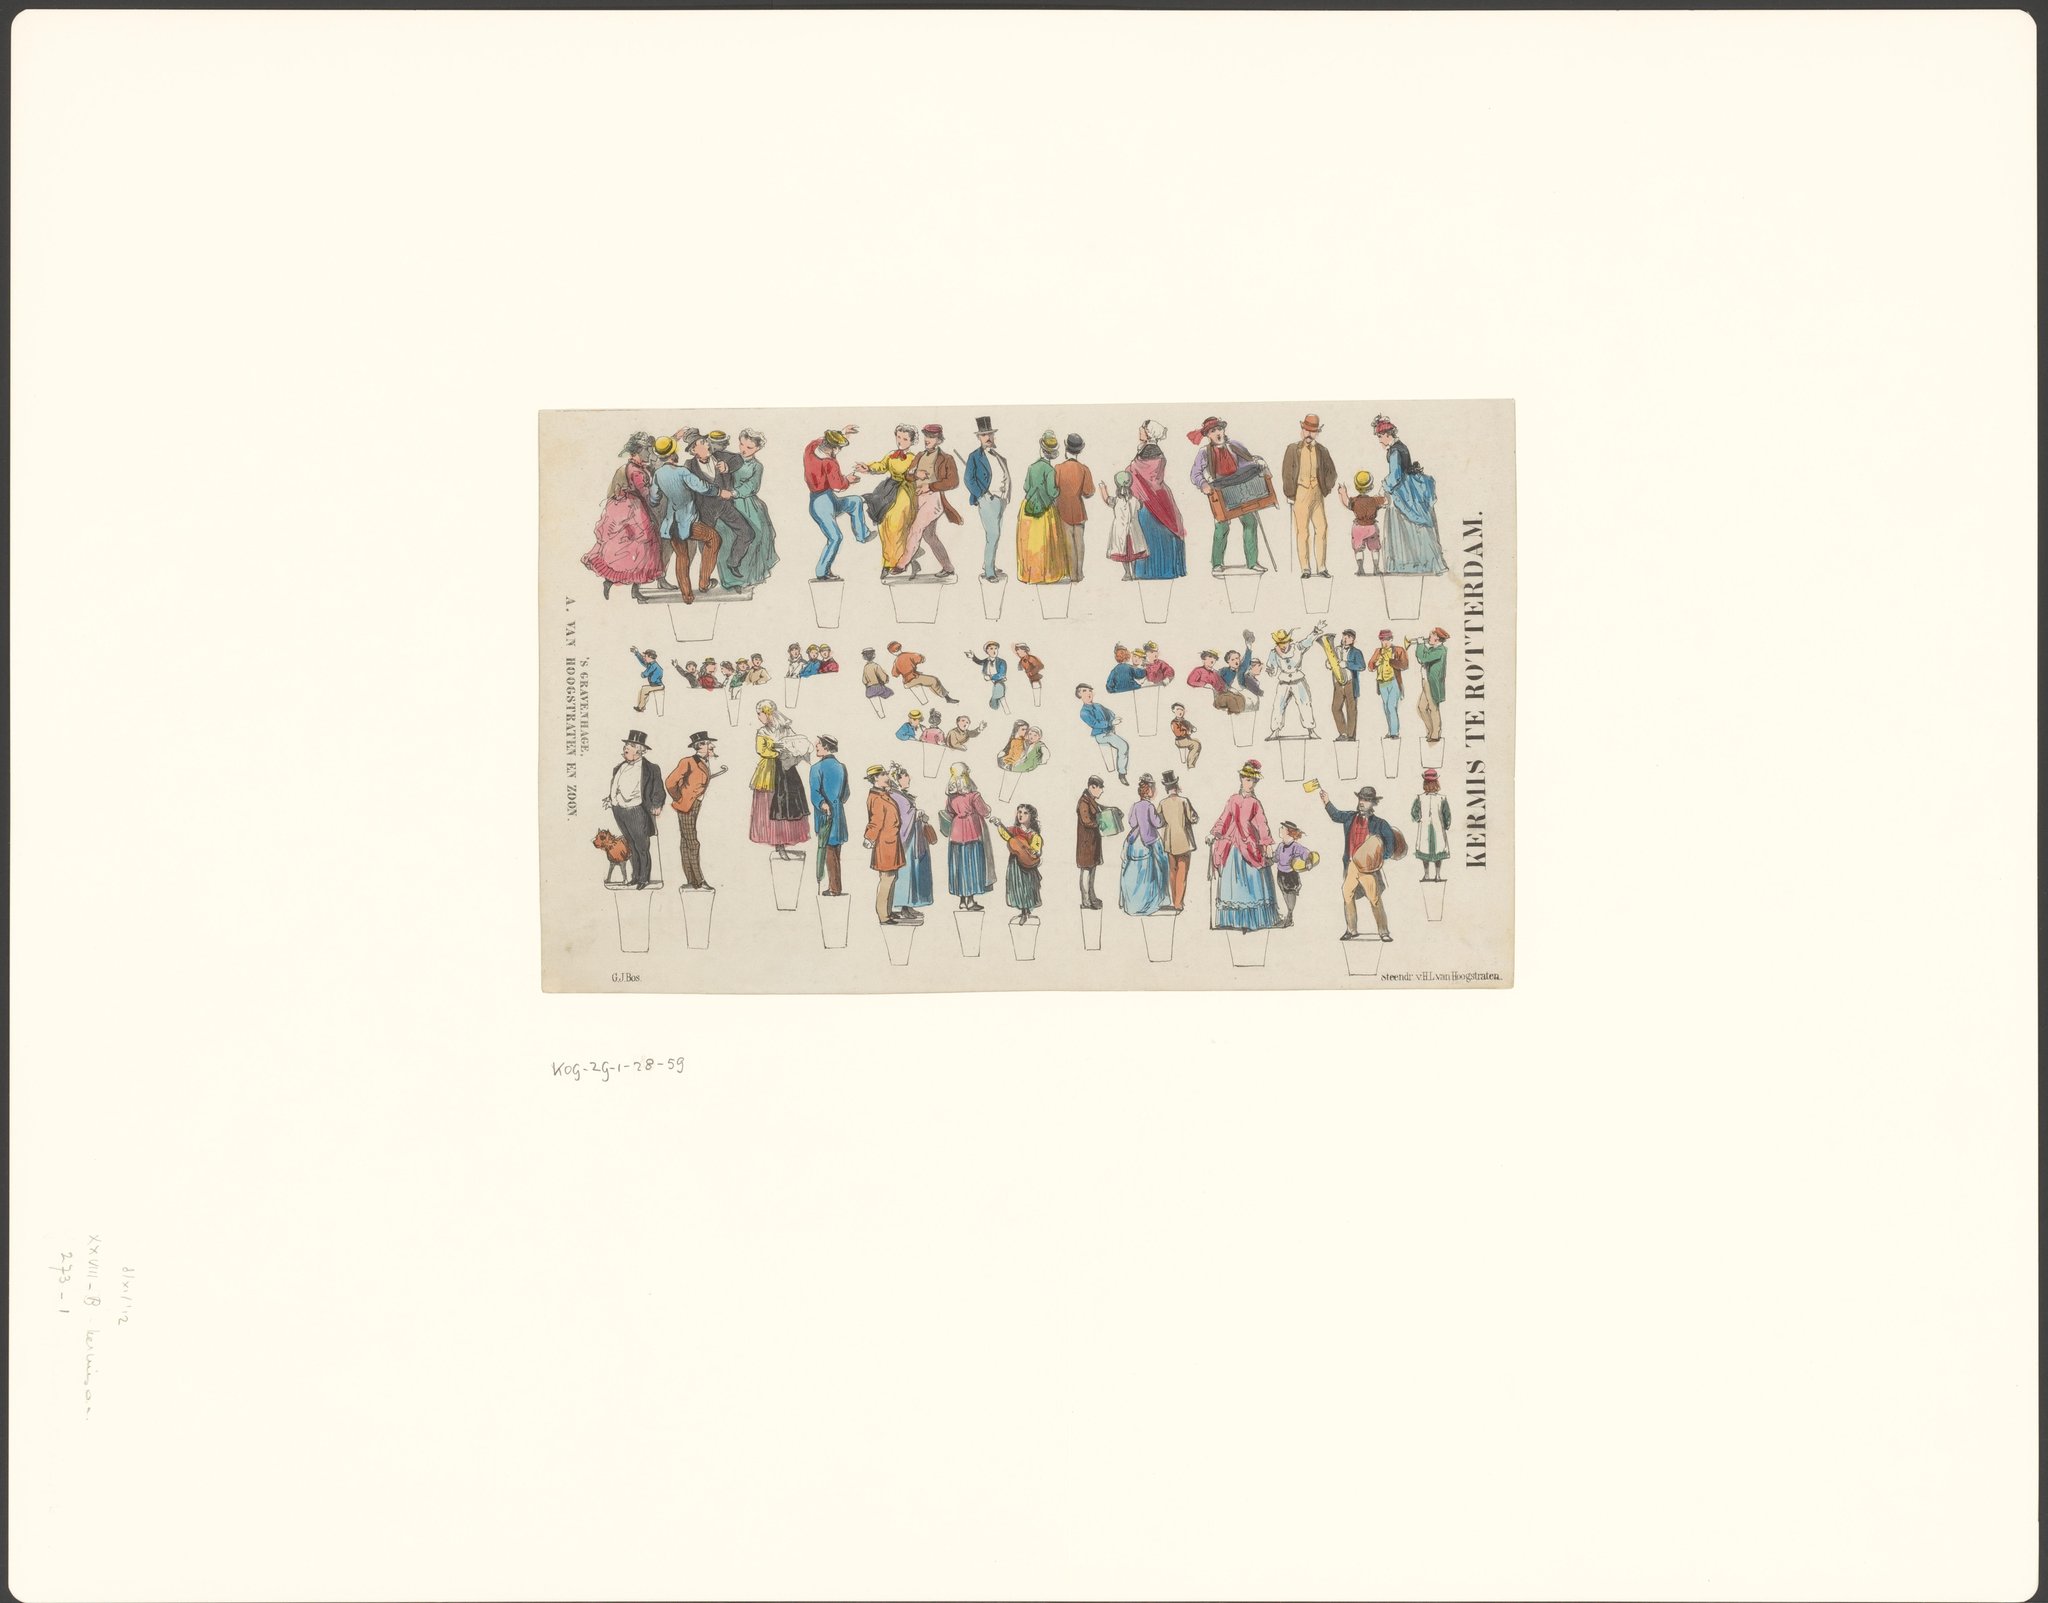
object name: print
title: Kermis te Rotterdam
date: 1854-1896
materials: paper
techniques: hand coloring, lithograph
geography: the hague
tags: pleasure fair and circus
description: Bezoekers van de kermis om uit te knippen en op te plakken. Onderwerpsrubrieken binnen de Atlas Zeden en Gewoonten: Zeden en Gewoonten in Engeren Zin. Volksleven. Volksfeesten. Circusmenschen, dierentemmers, acrobaten, goochelaars, en dergelijken.